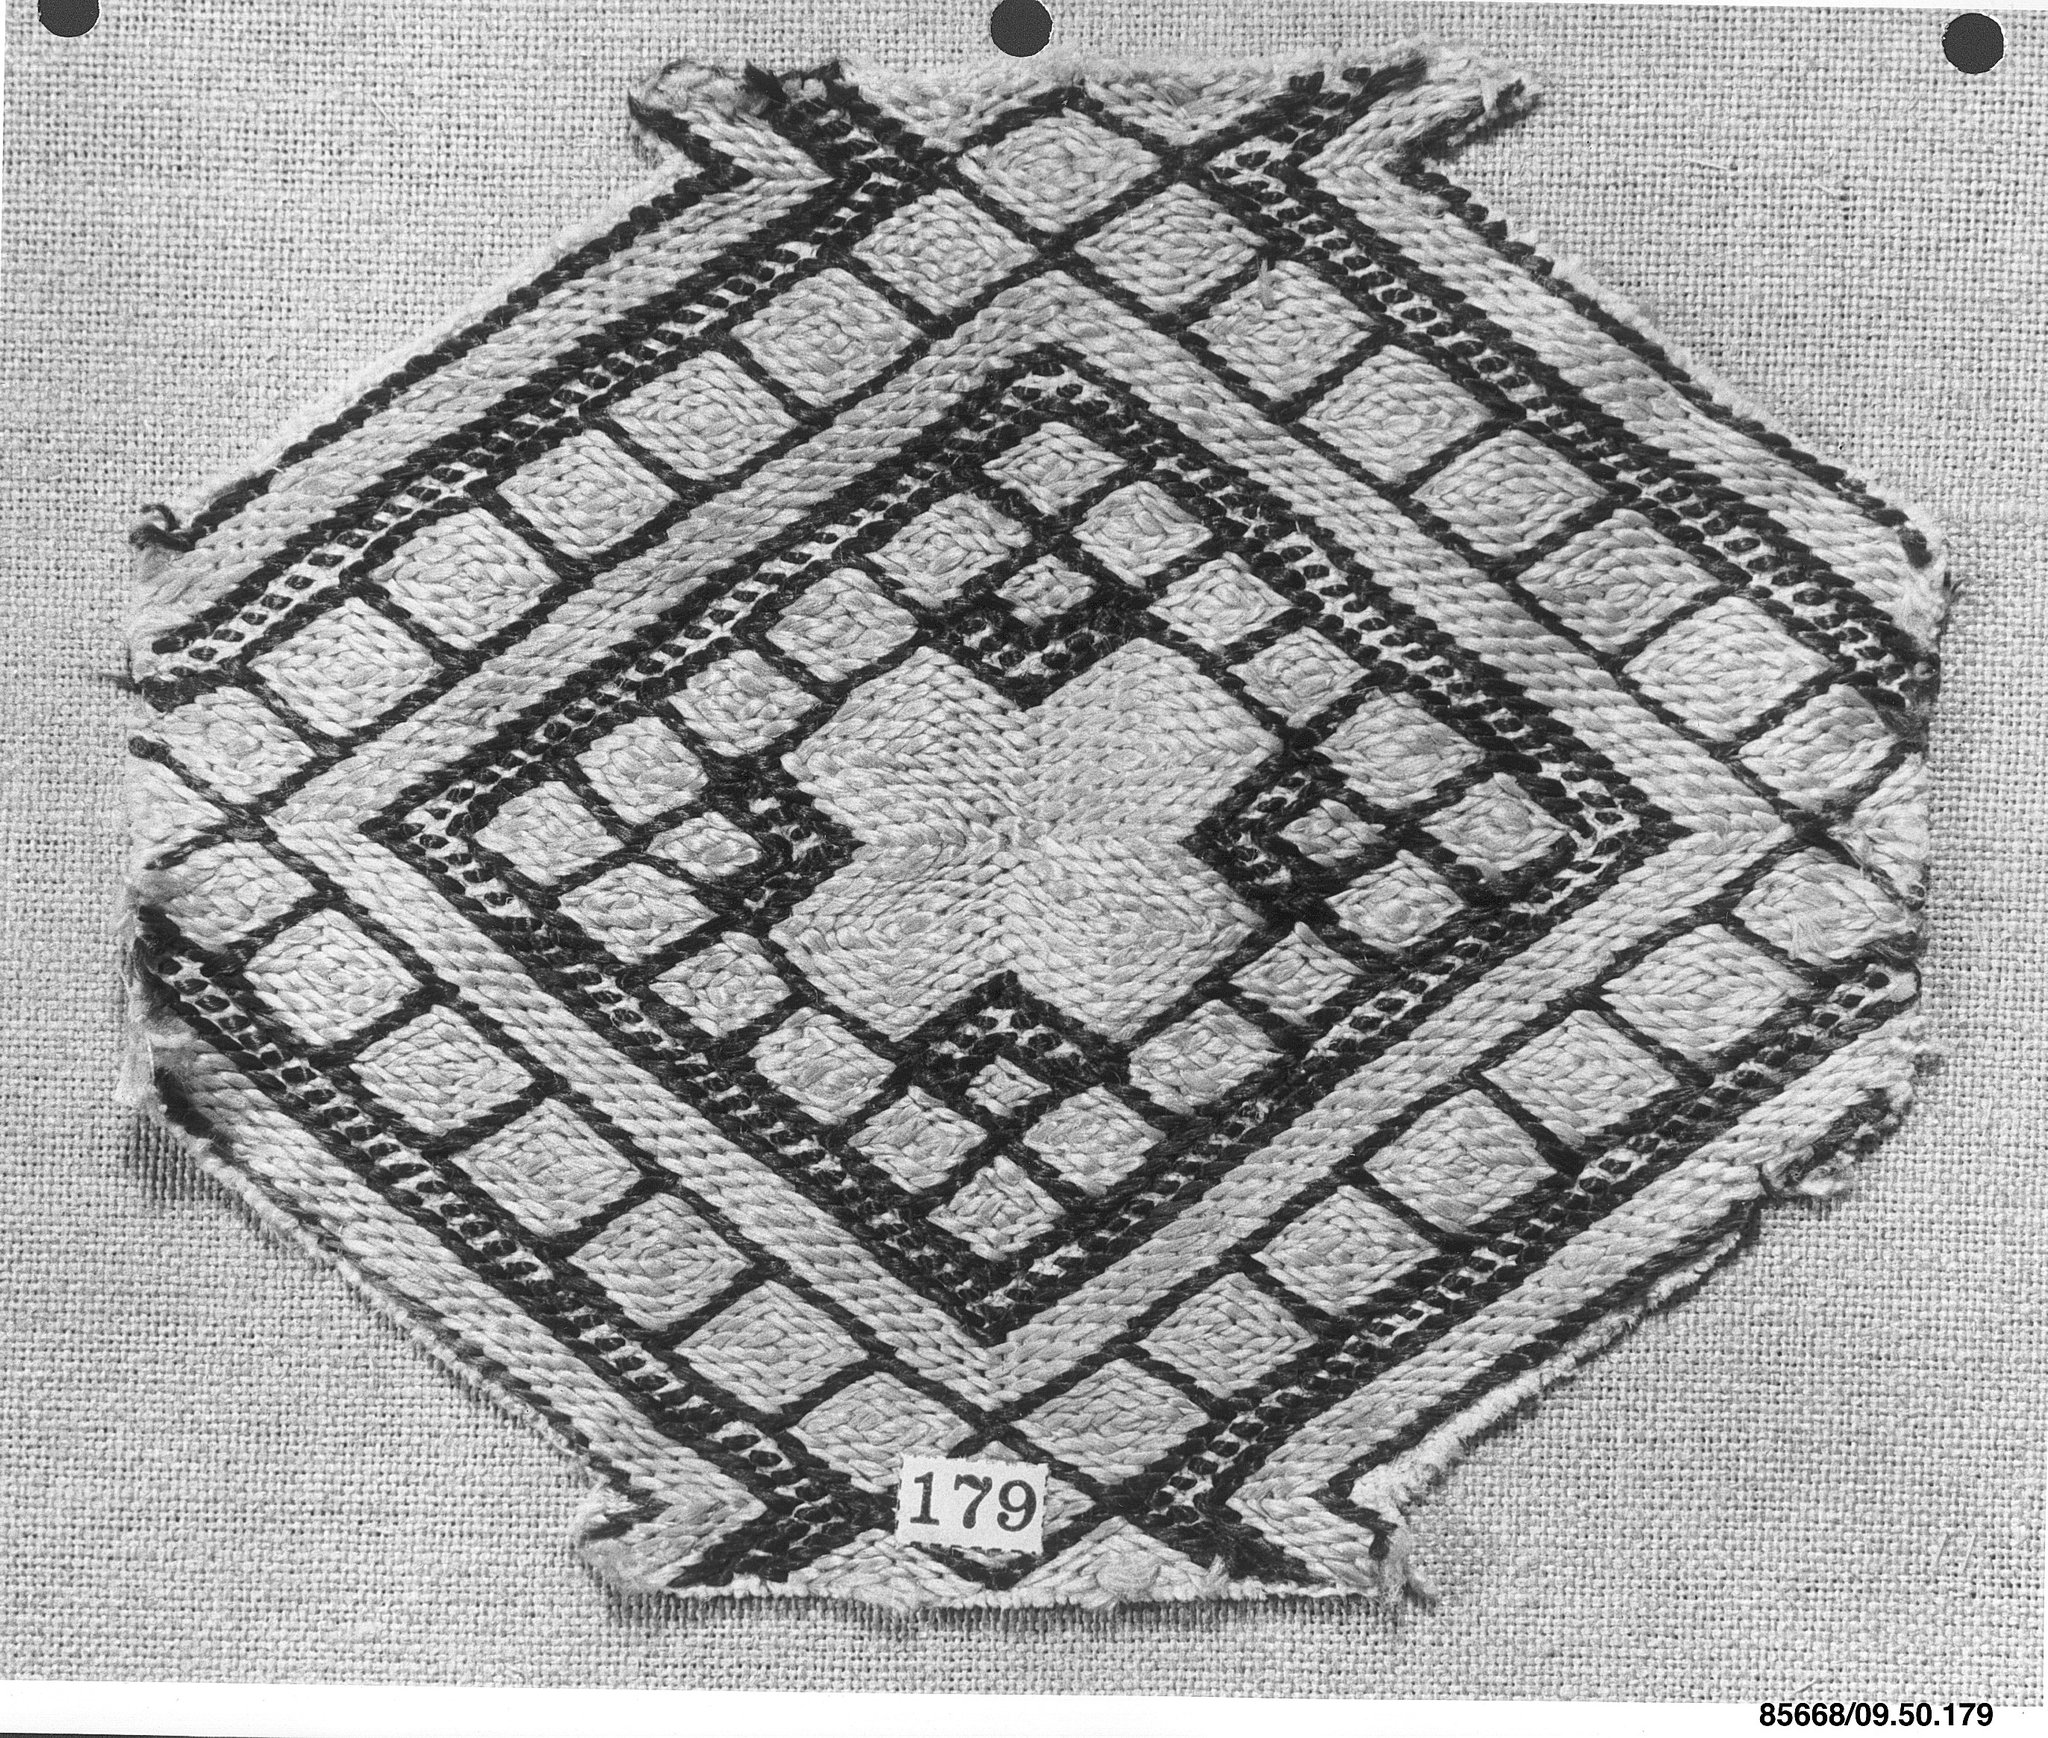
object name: costume fragment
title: Peasant costume fragment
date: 1701-1900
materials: canvas